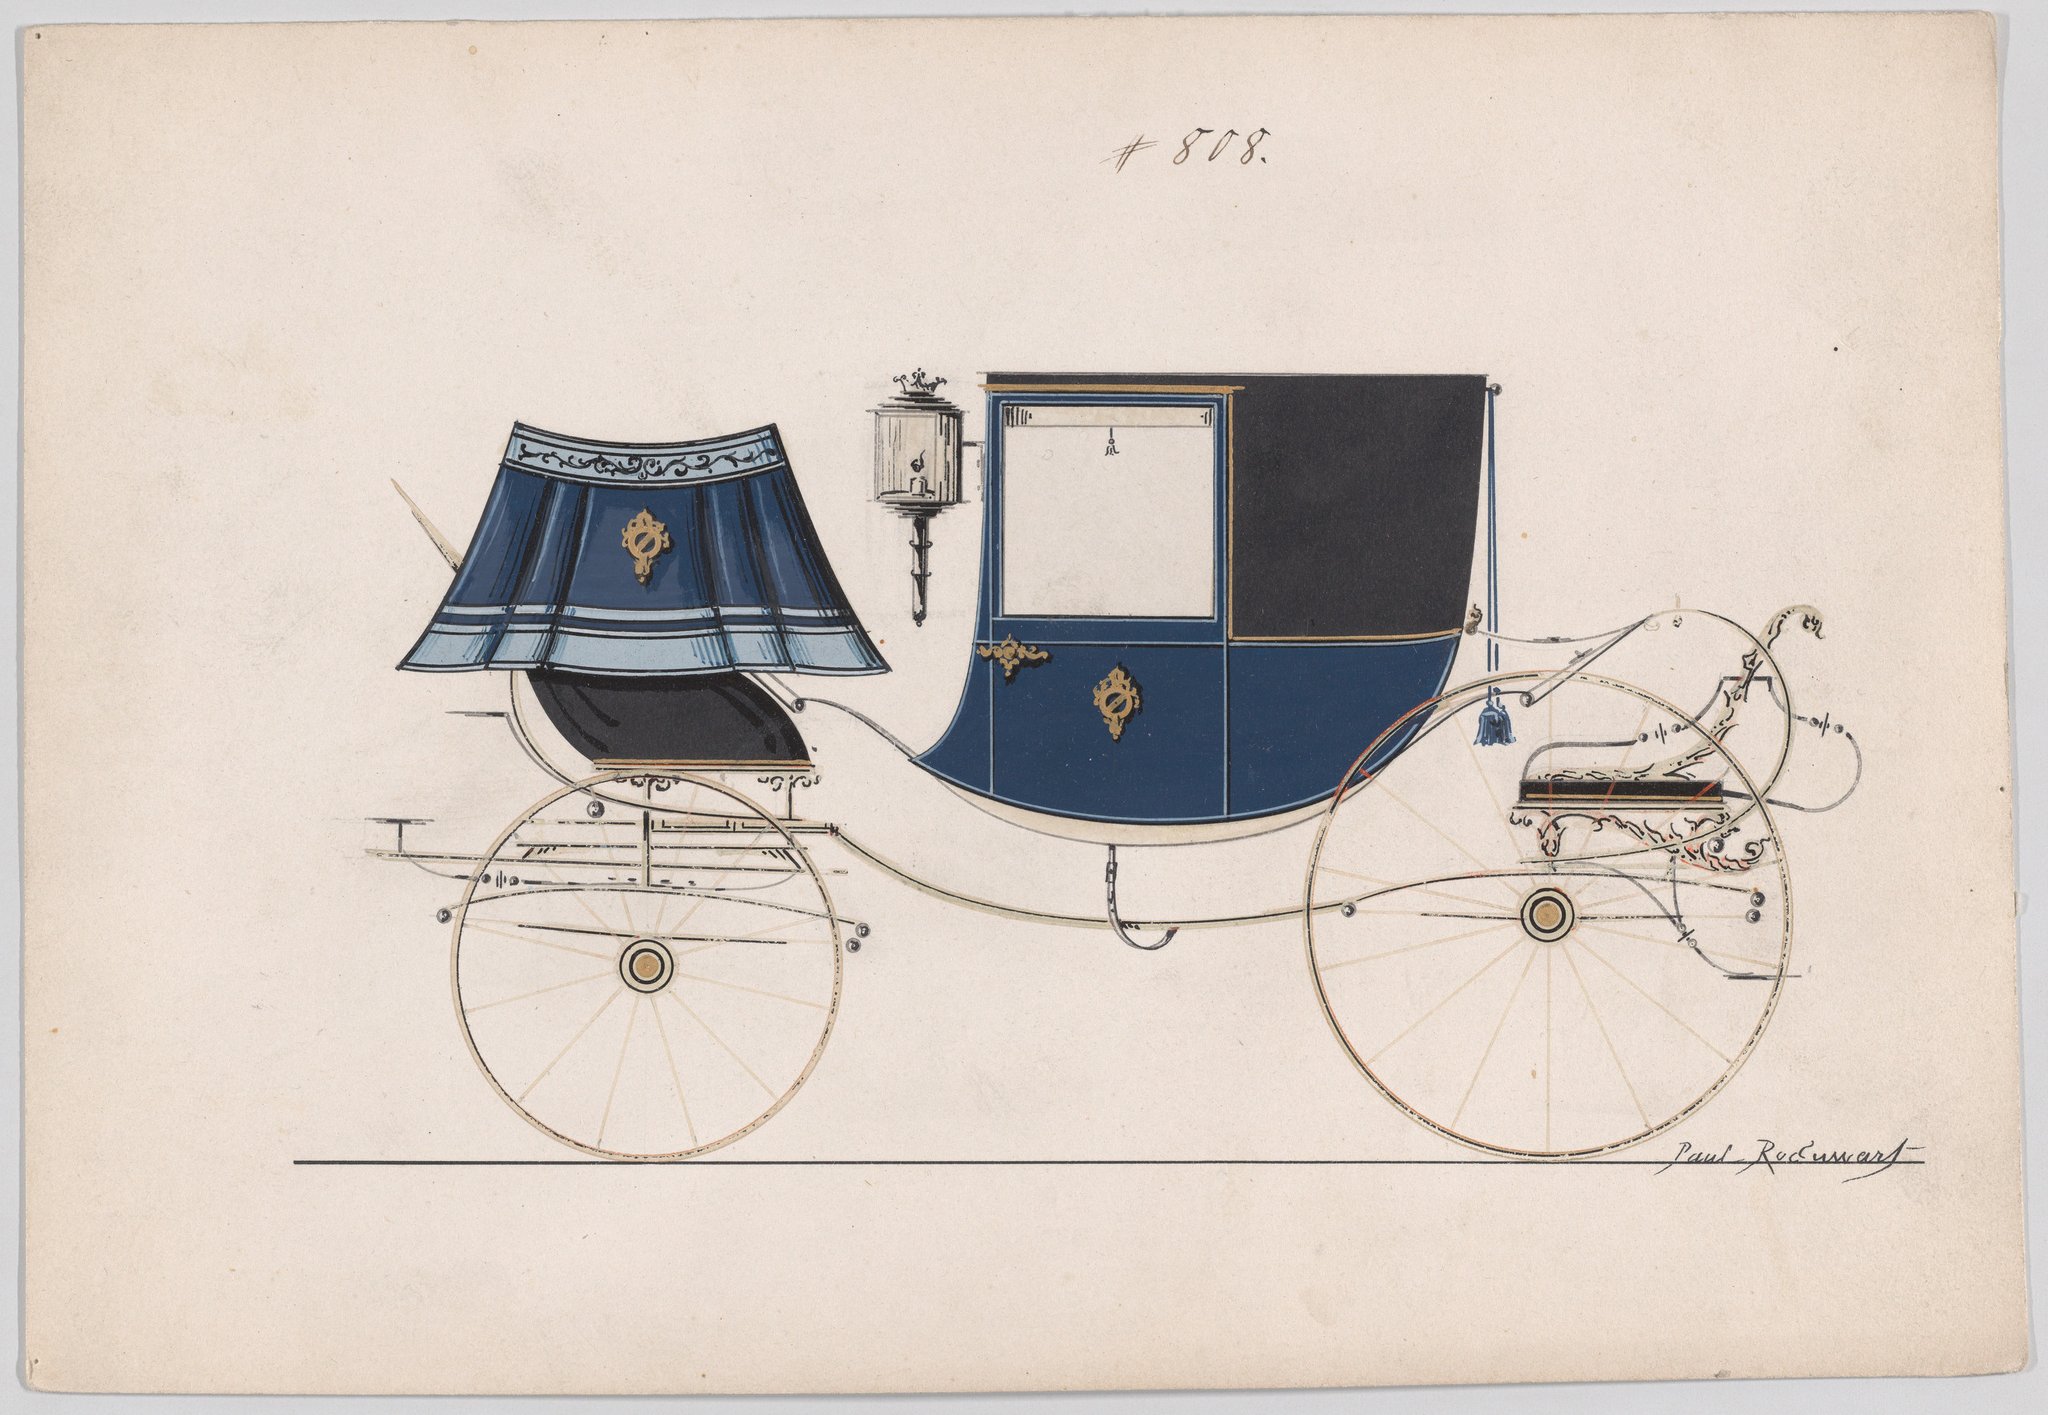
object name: drawing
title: Chariot #808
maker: brewster & co.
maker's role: manufacturer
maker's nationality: american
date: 1870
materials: gouache, gum arabic, ink, watercolor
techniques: pen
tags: carriages